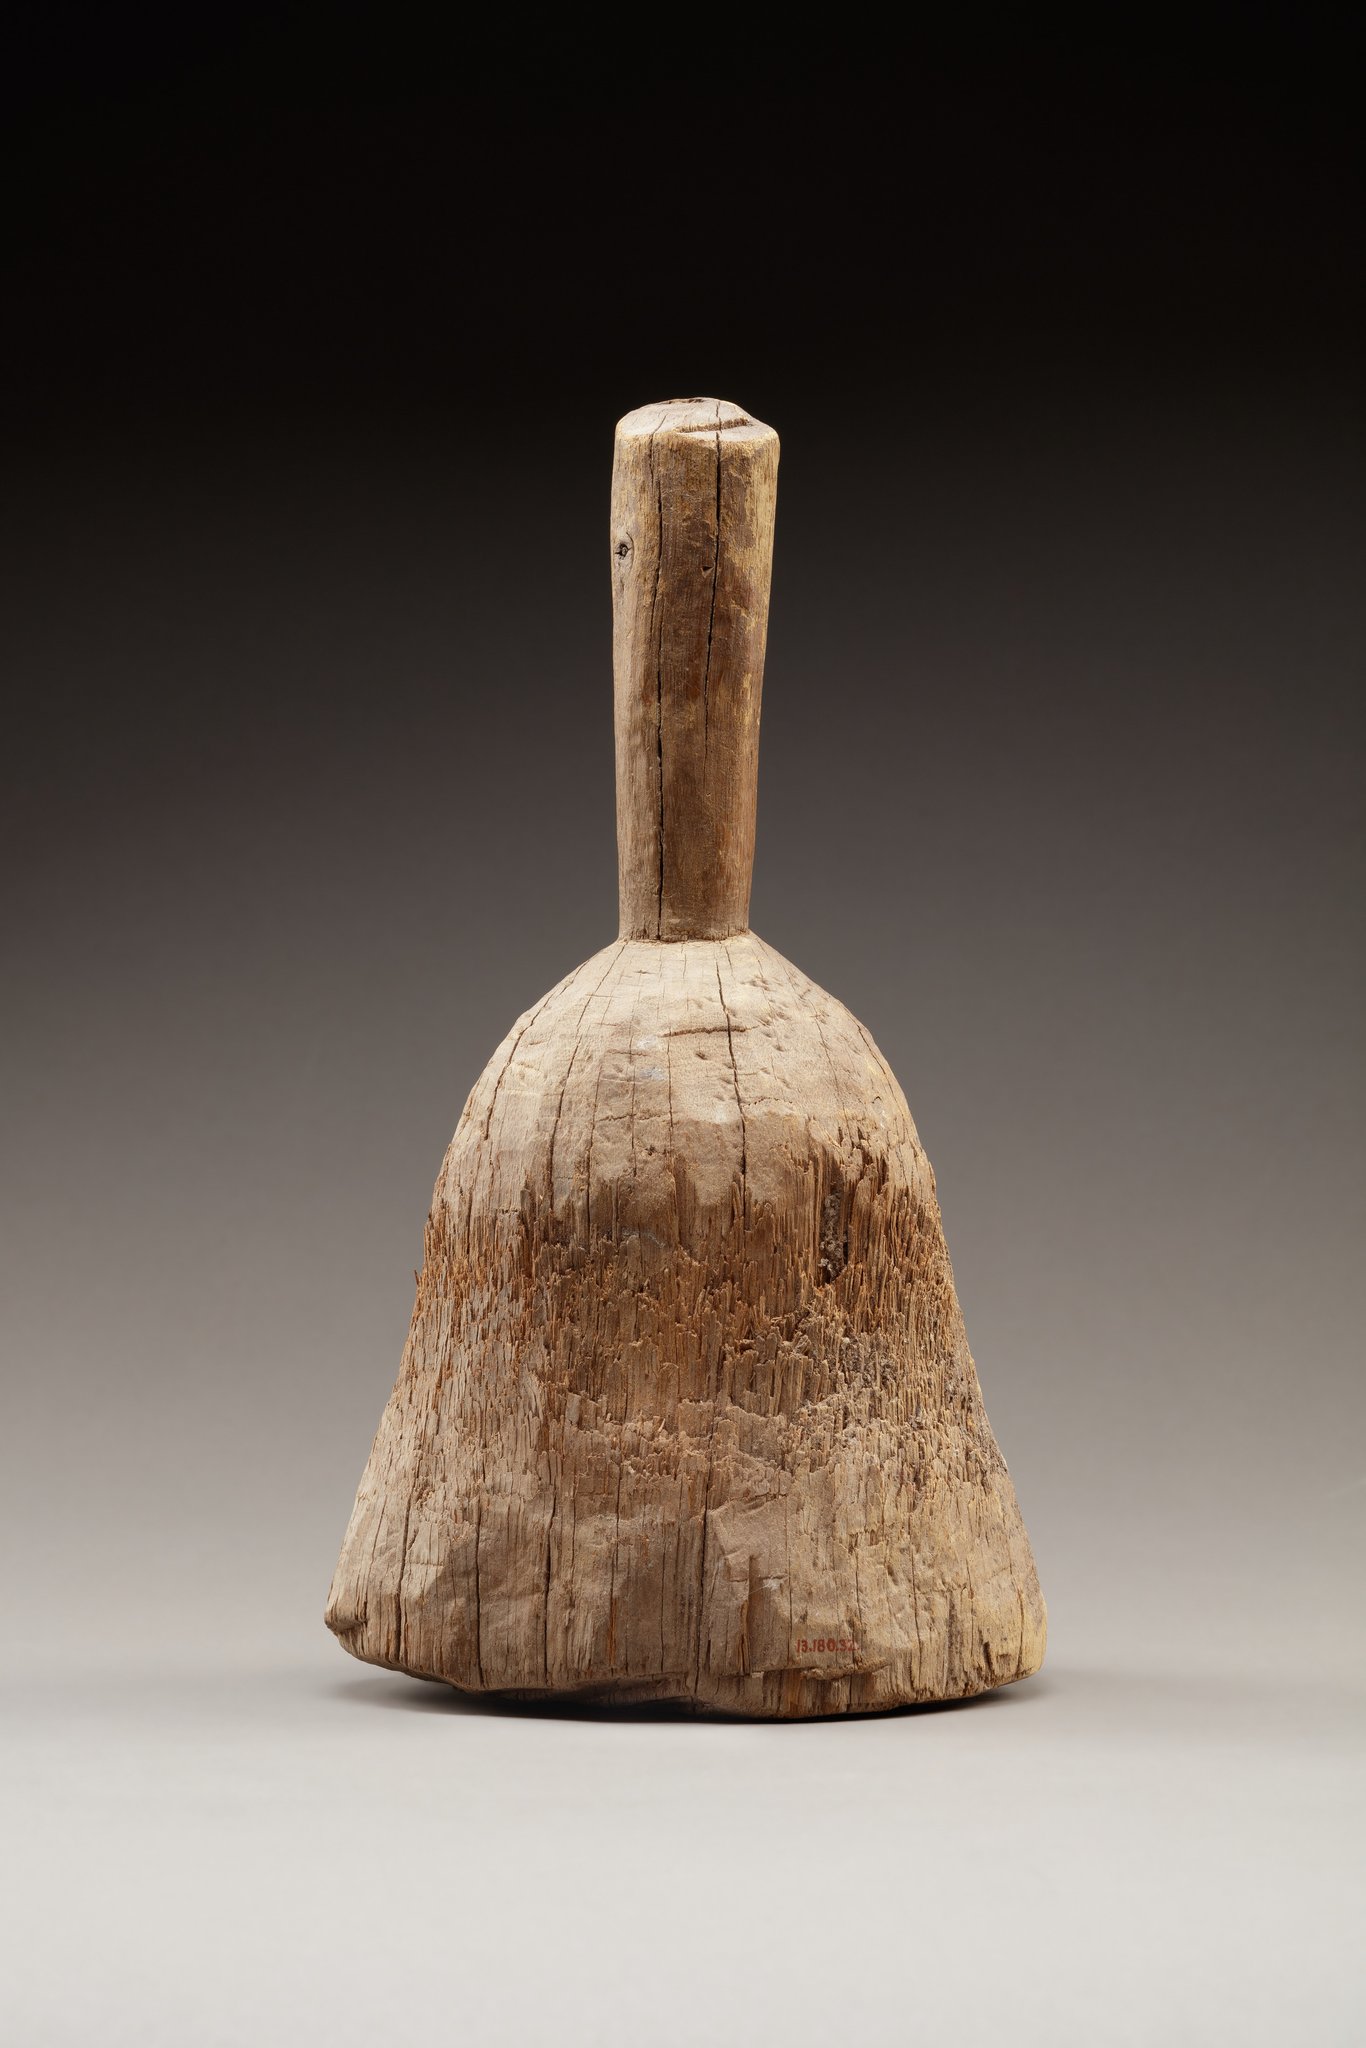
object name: mallet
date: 1200 BCE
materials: wood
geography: egypt